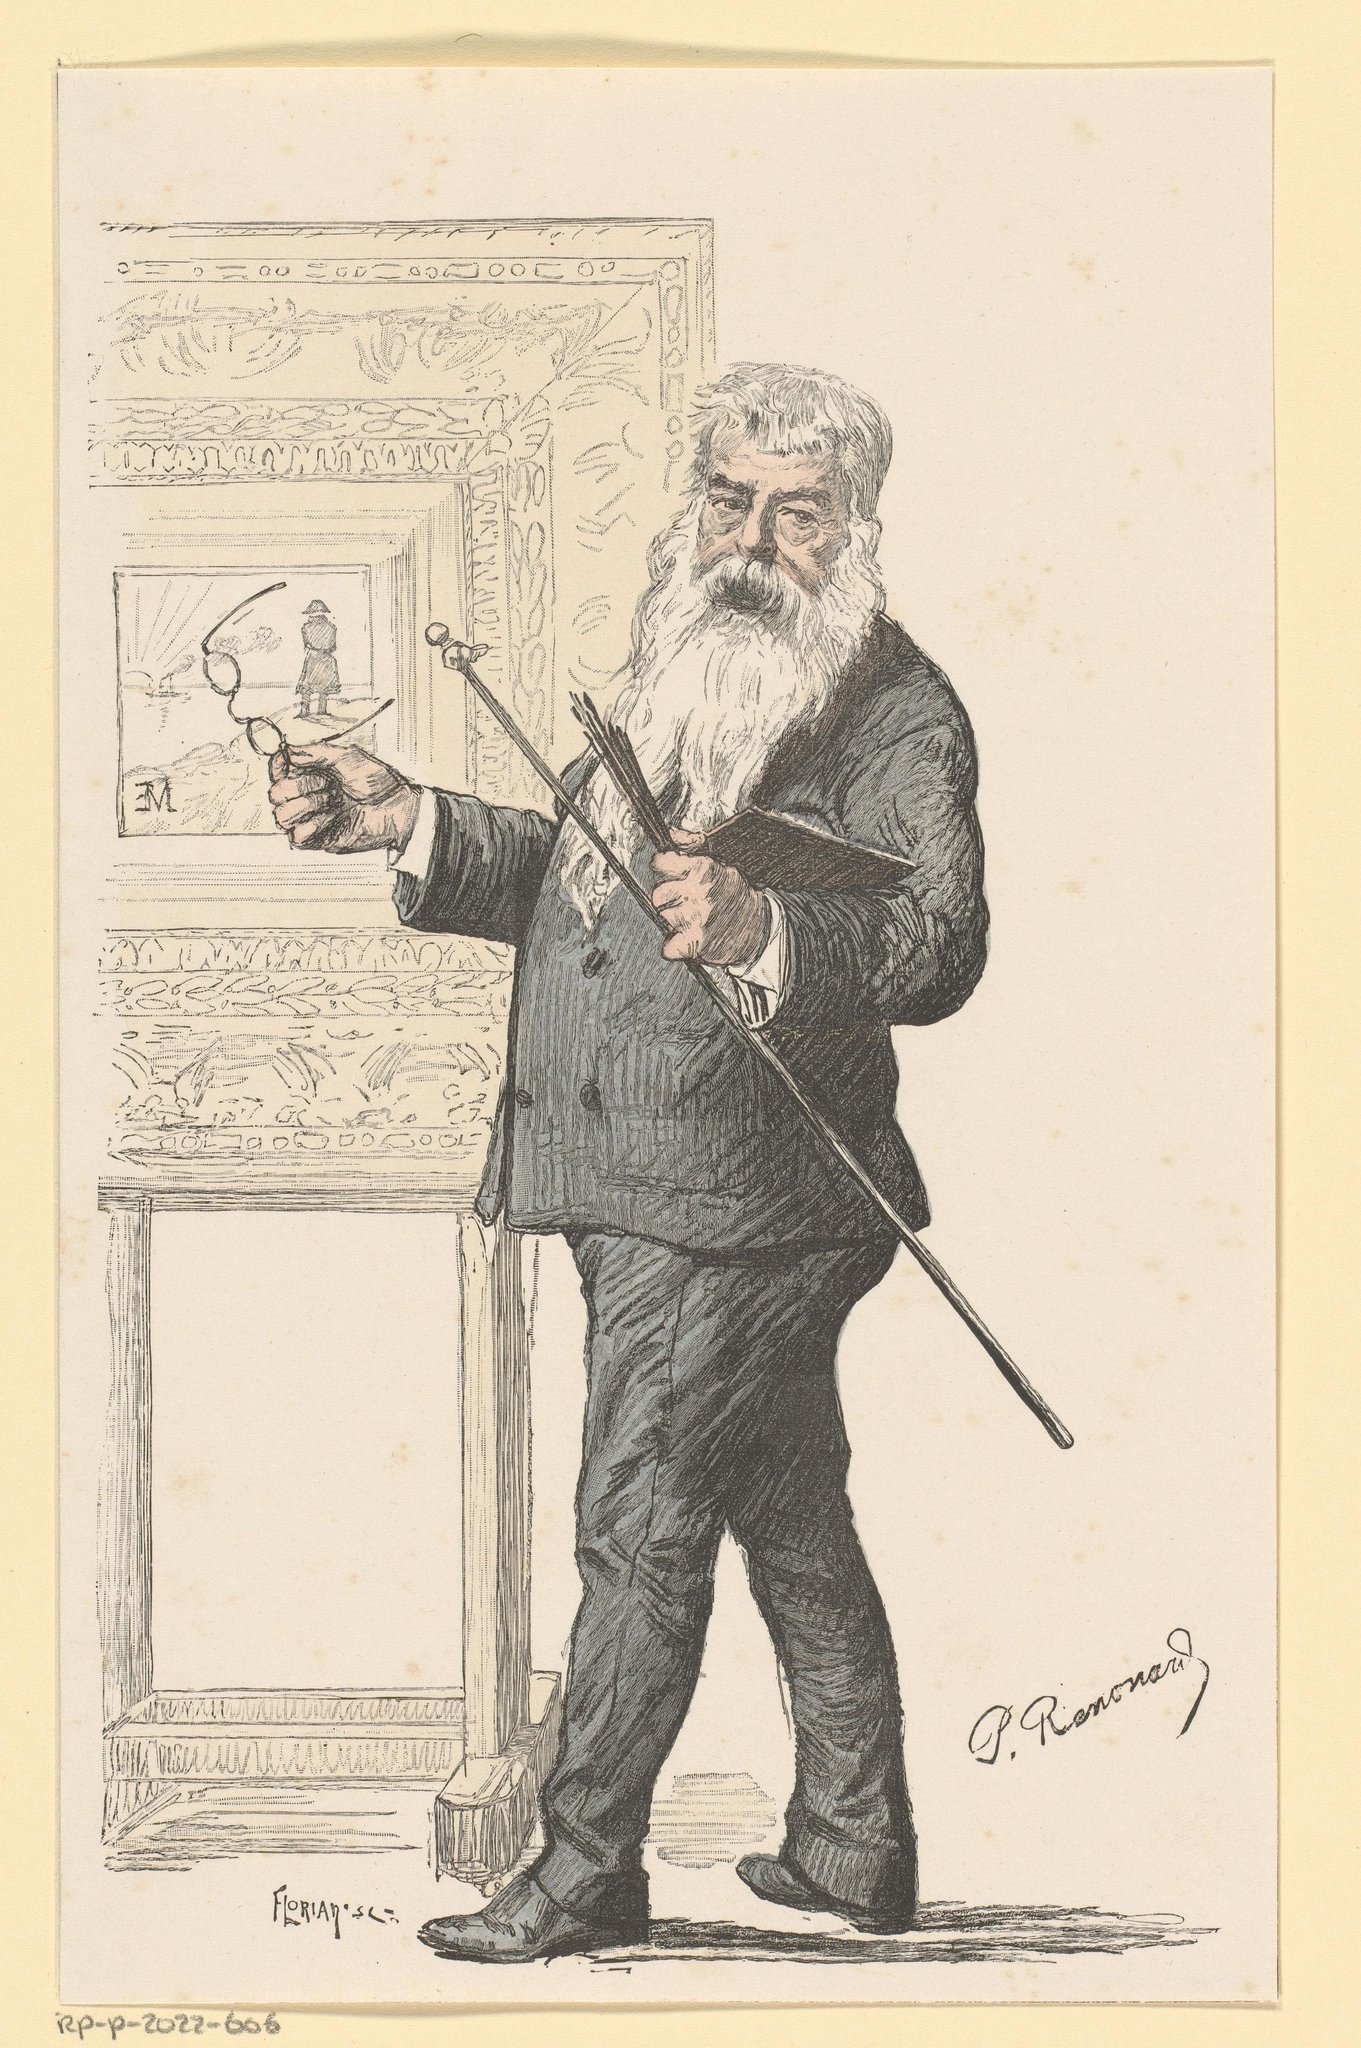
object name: print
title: Portret van Jean Louis Erneste Meissonier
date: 1880-1926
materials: paper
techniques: hand coloring, engraving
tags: jean louis ernest meissonier, historical persons